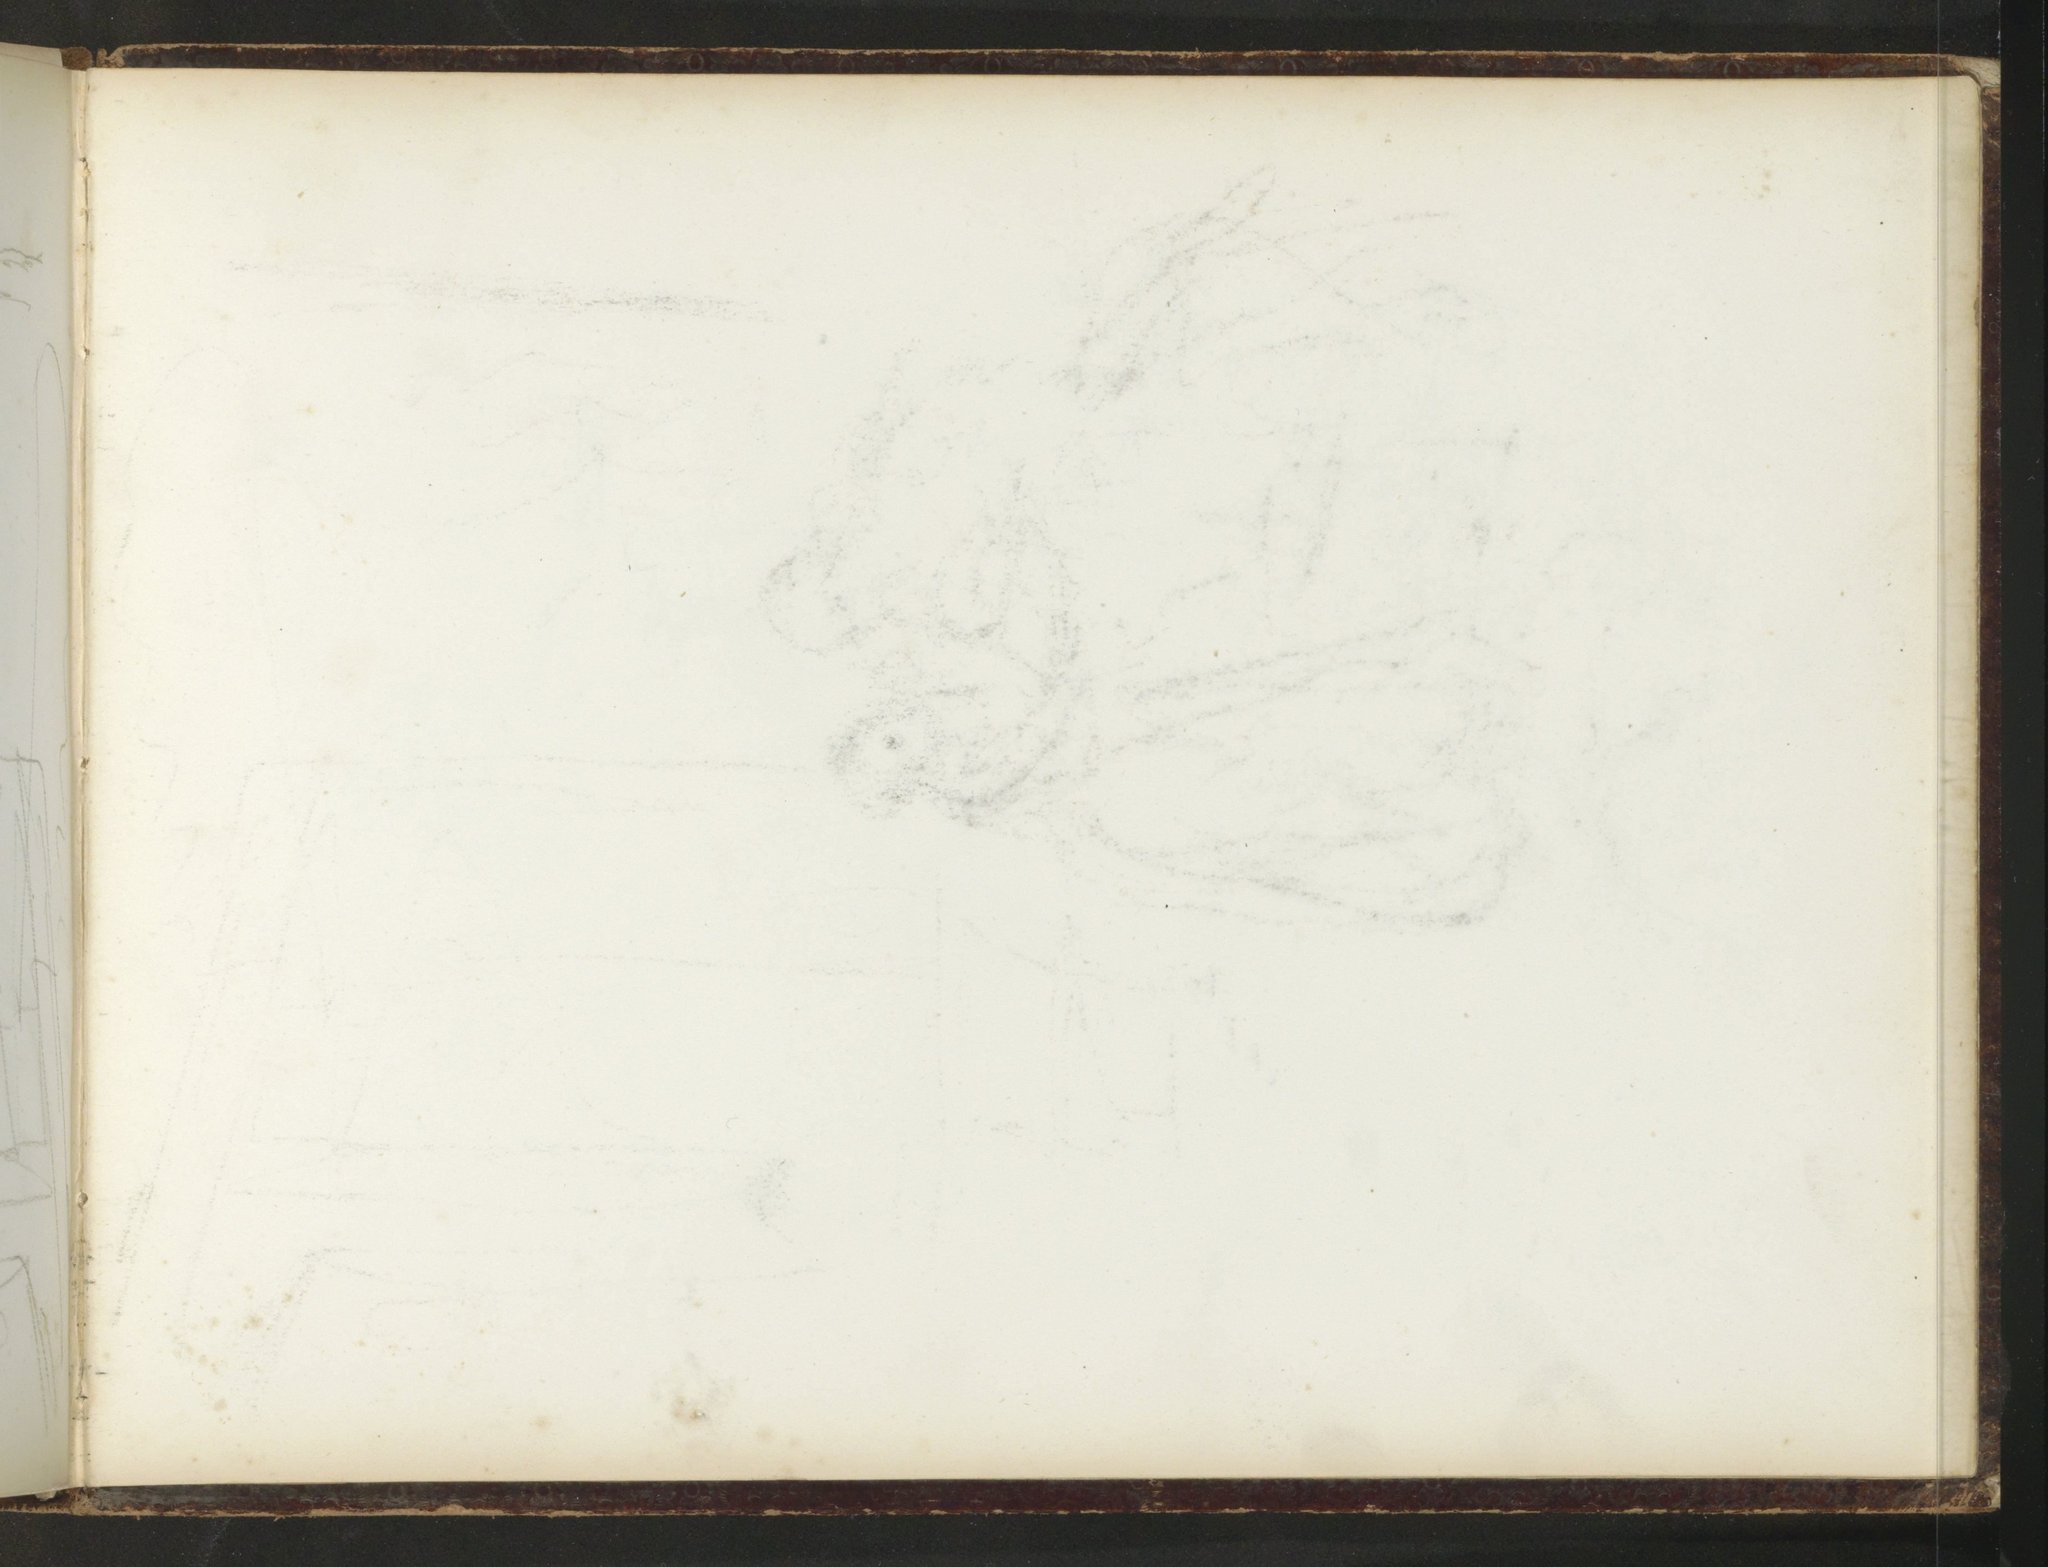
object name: sketchbook leaf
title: Abklatsch van de krijttekening op blad 43 verso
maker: reinier craeyvanger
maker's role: draughtsman, print maker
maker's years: 1812-1880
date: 1822-1880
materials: paper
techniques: printmaking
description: Blad 44 recto uit een schetsboek met 45 bladen.